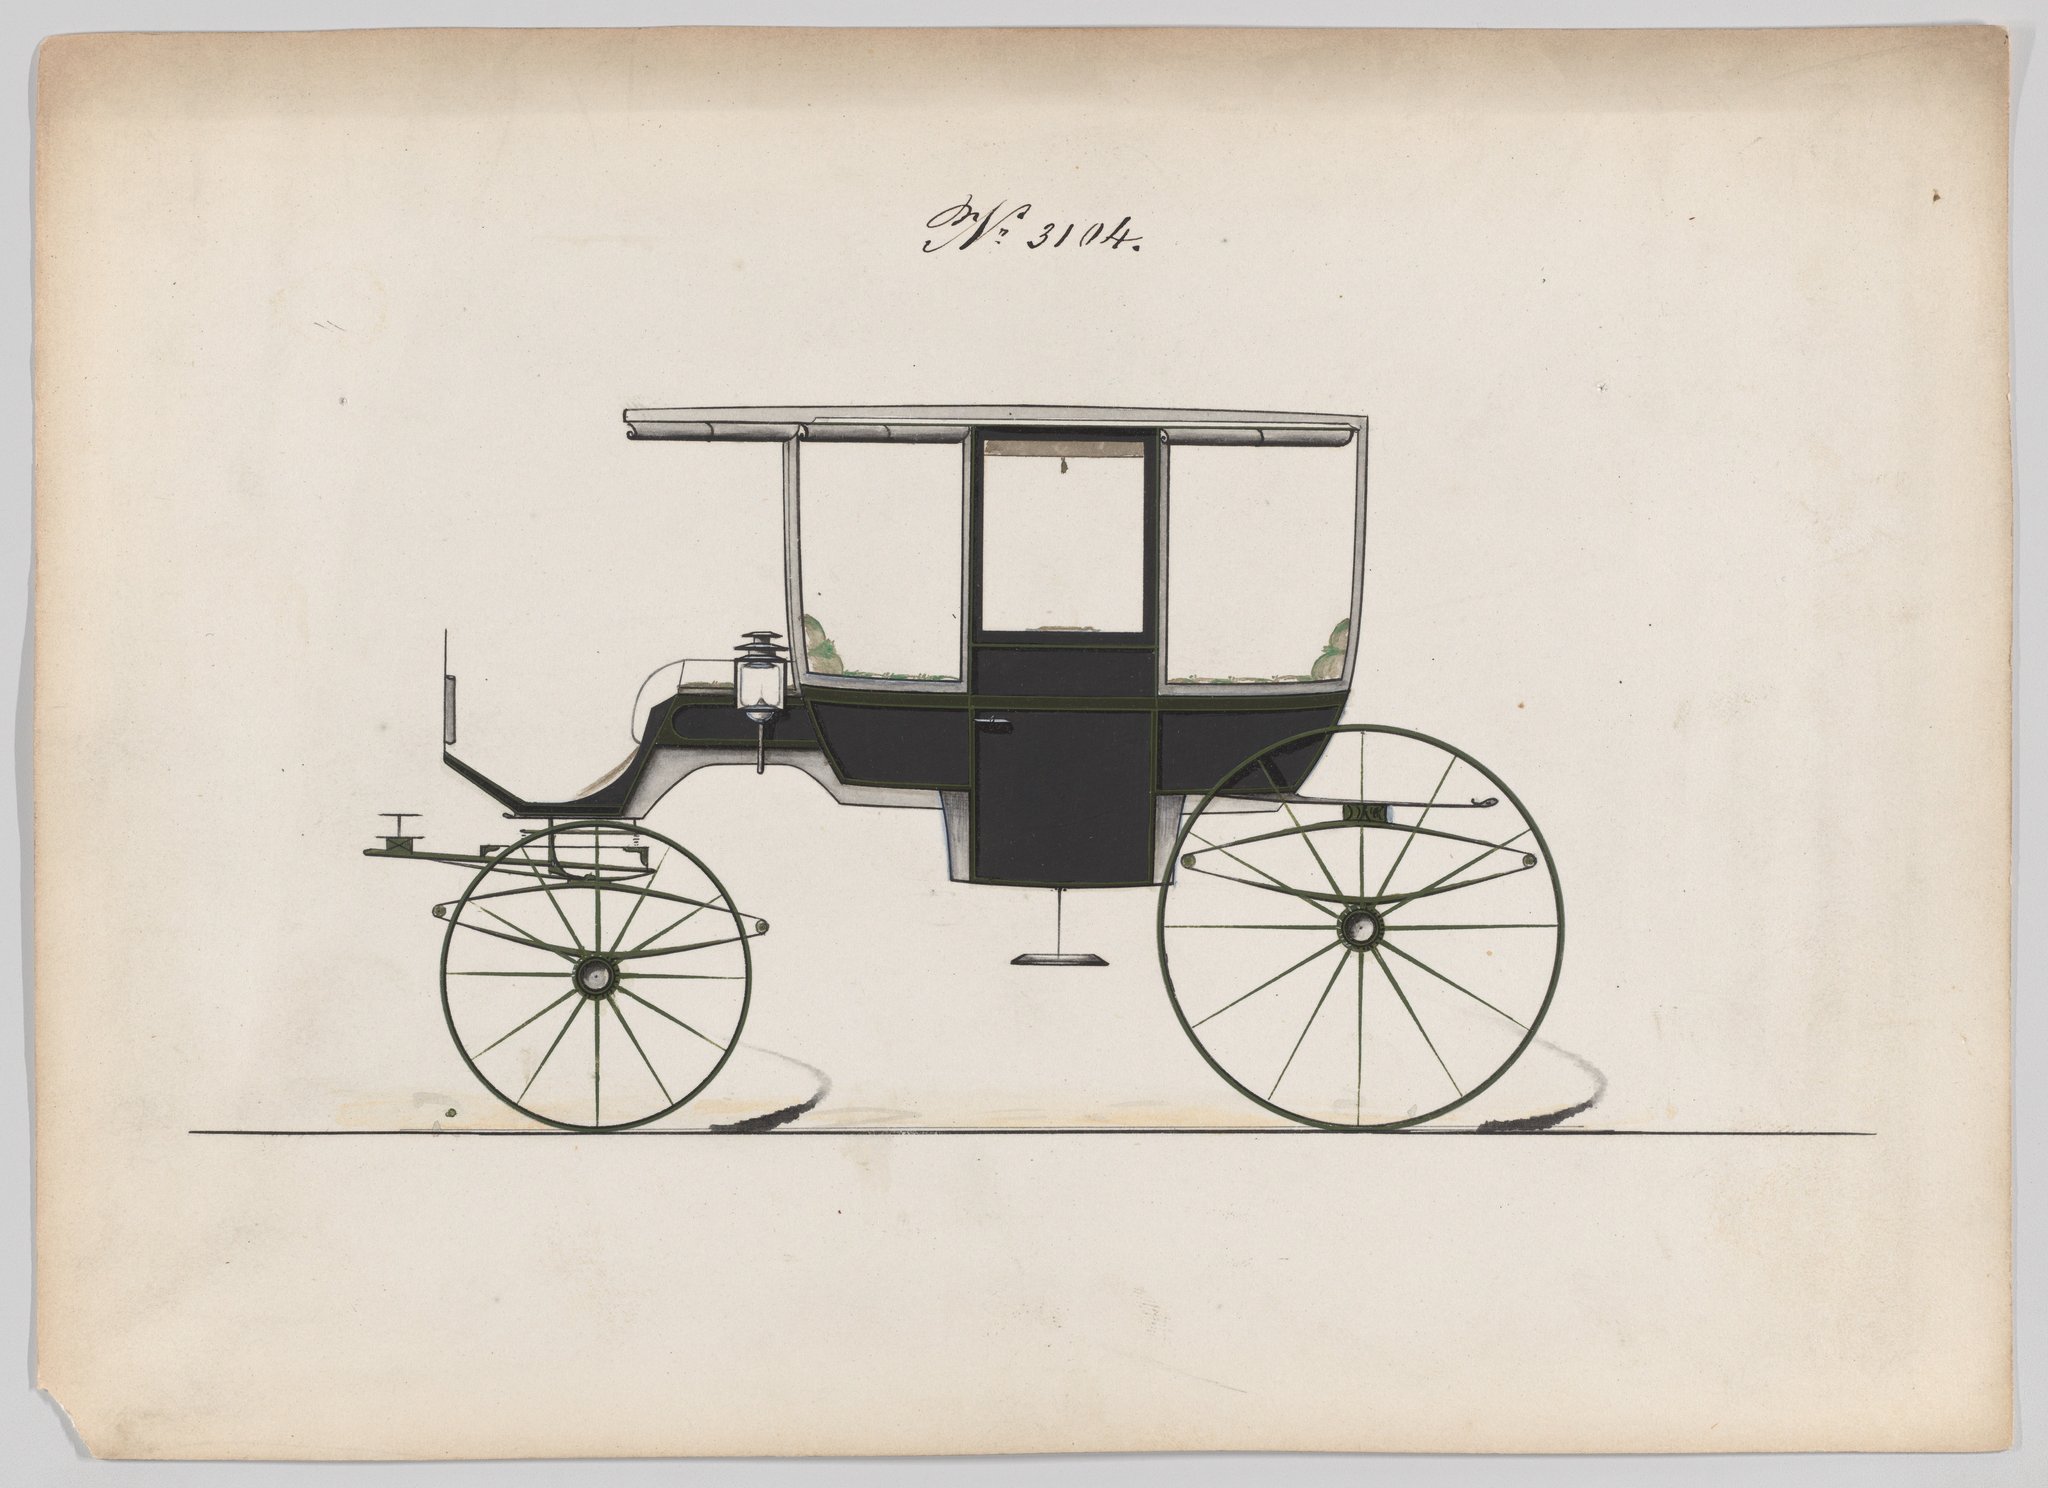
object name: drawing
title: Design for 6 seat Rockaway, no. 3104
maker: brewster & co.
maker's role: manufacturer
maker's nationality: american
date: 1875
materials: gouache, gum arabic, ink, watercolor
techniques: pen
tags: carriages